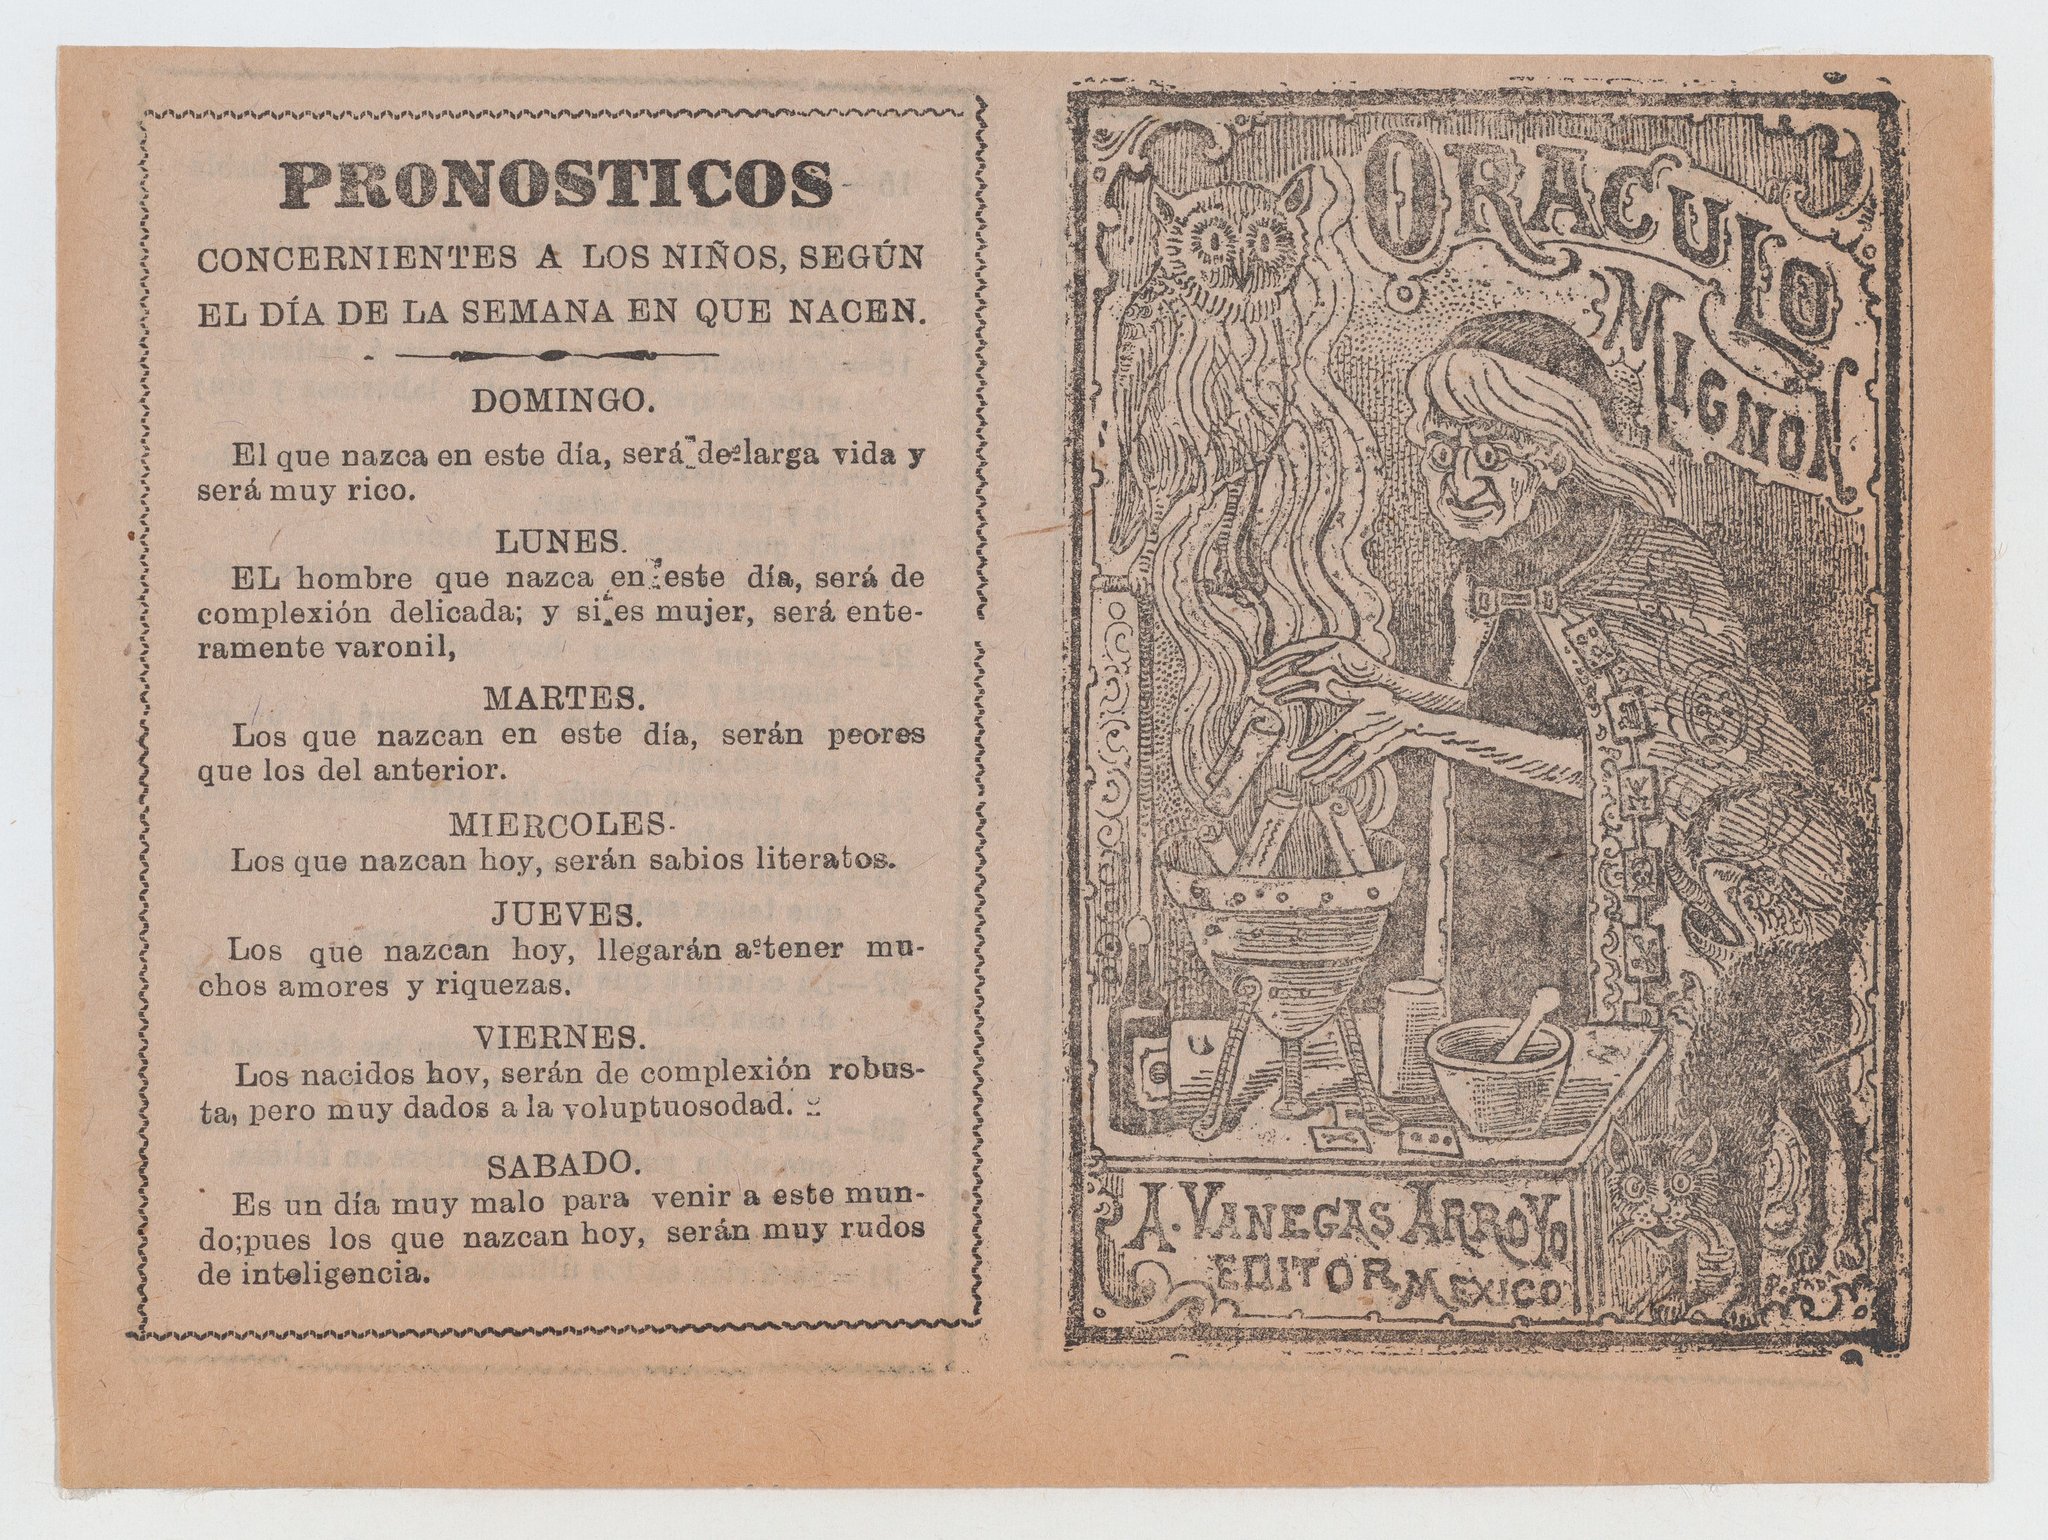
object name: print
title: Cover for 'Oraculo Mignon', a witch brewing a potion in a cauldron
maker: josé guadalupe posada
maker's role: artist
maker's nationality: mexican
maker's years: 1852-1913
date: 1880-1910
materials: paper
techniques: letterpress, lithography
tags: women,owls,witches